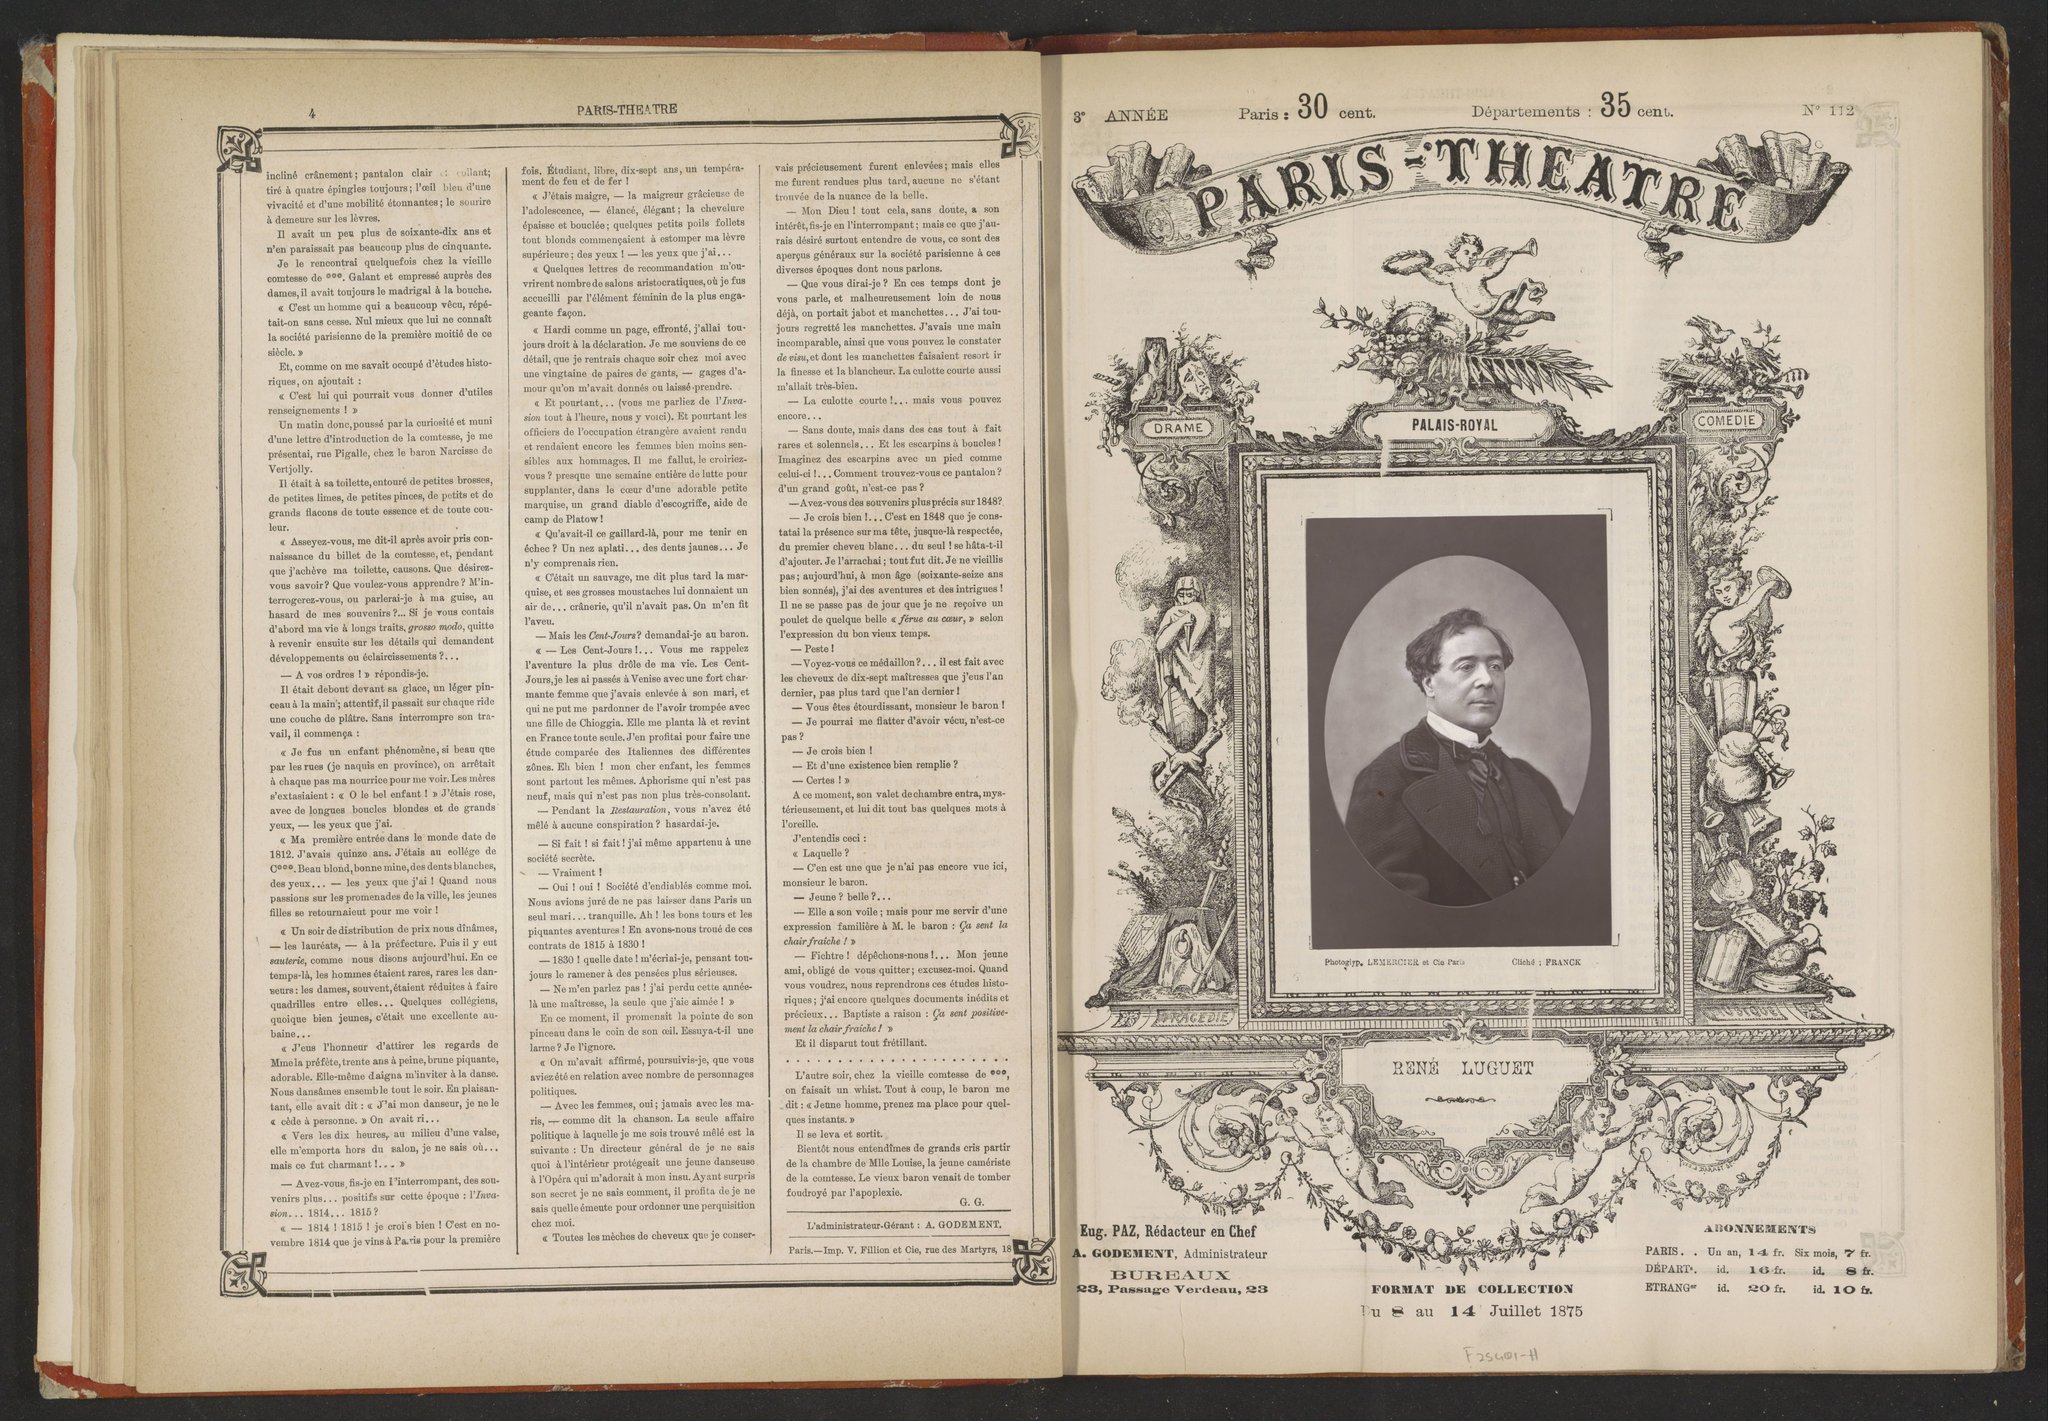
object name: page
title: René Luguet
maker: françois marie louis franck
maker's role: fotograaf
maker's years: 1816-1906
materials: paper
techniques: woodburytype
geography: paris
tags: acteur, rené luguet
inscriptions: inscription: ‘Du 8 au 14 Juillet 1875’, number: ‘No 112’